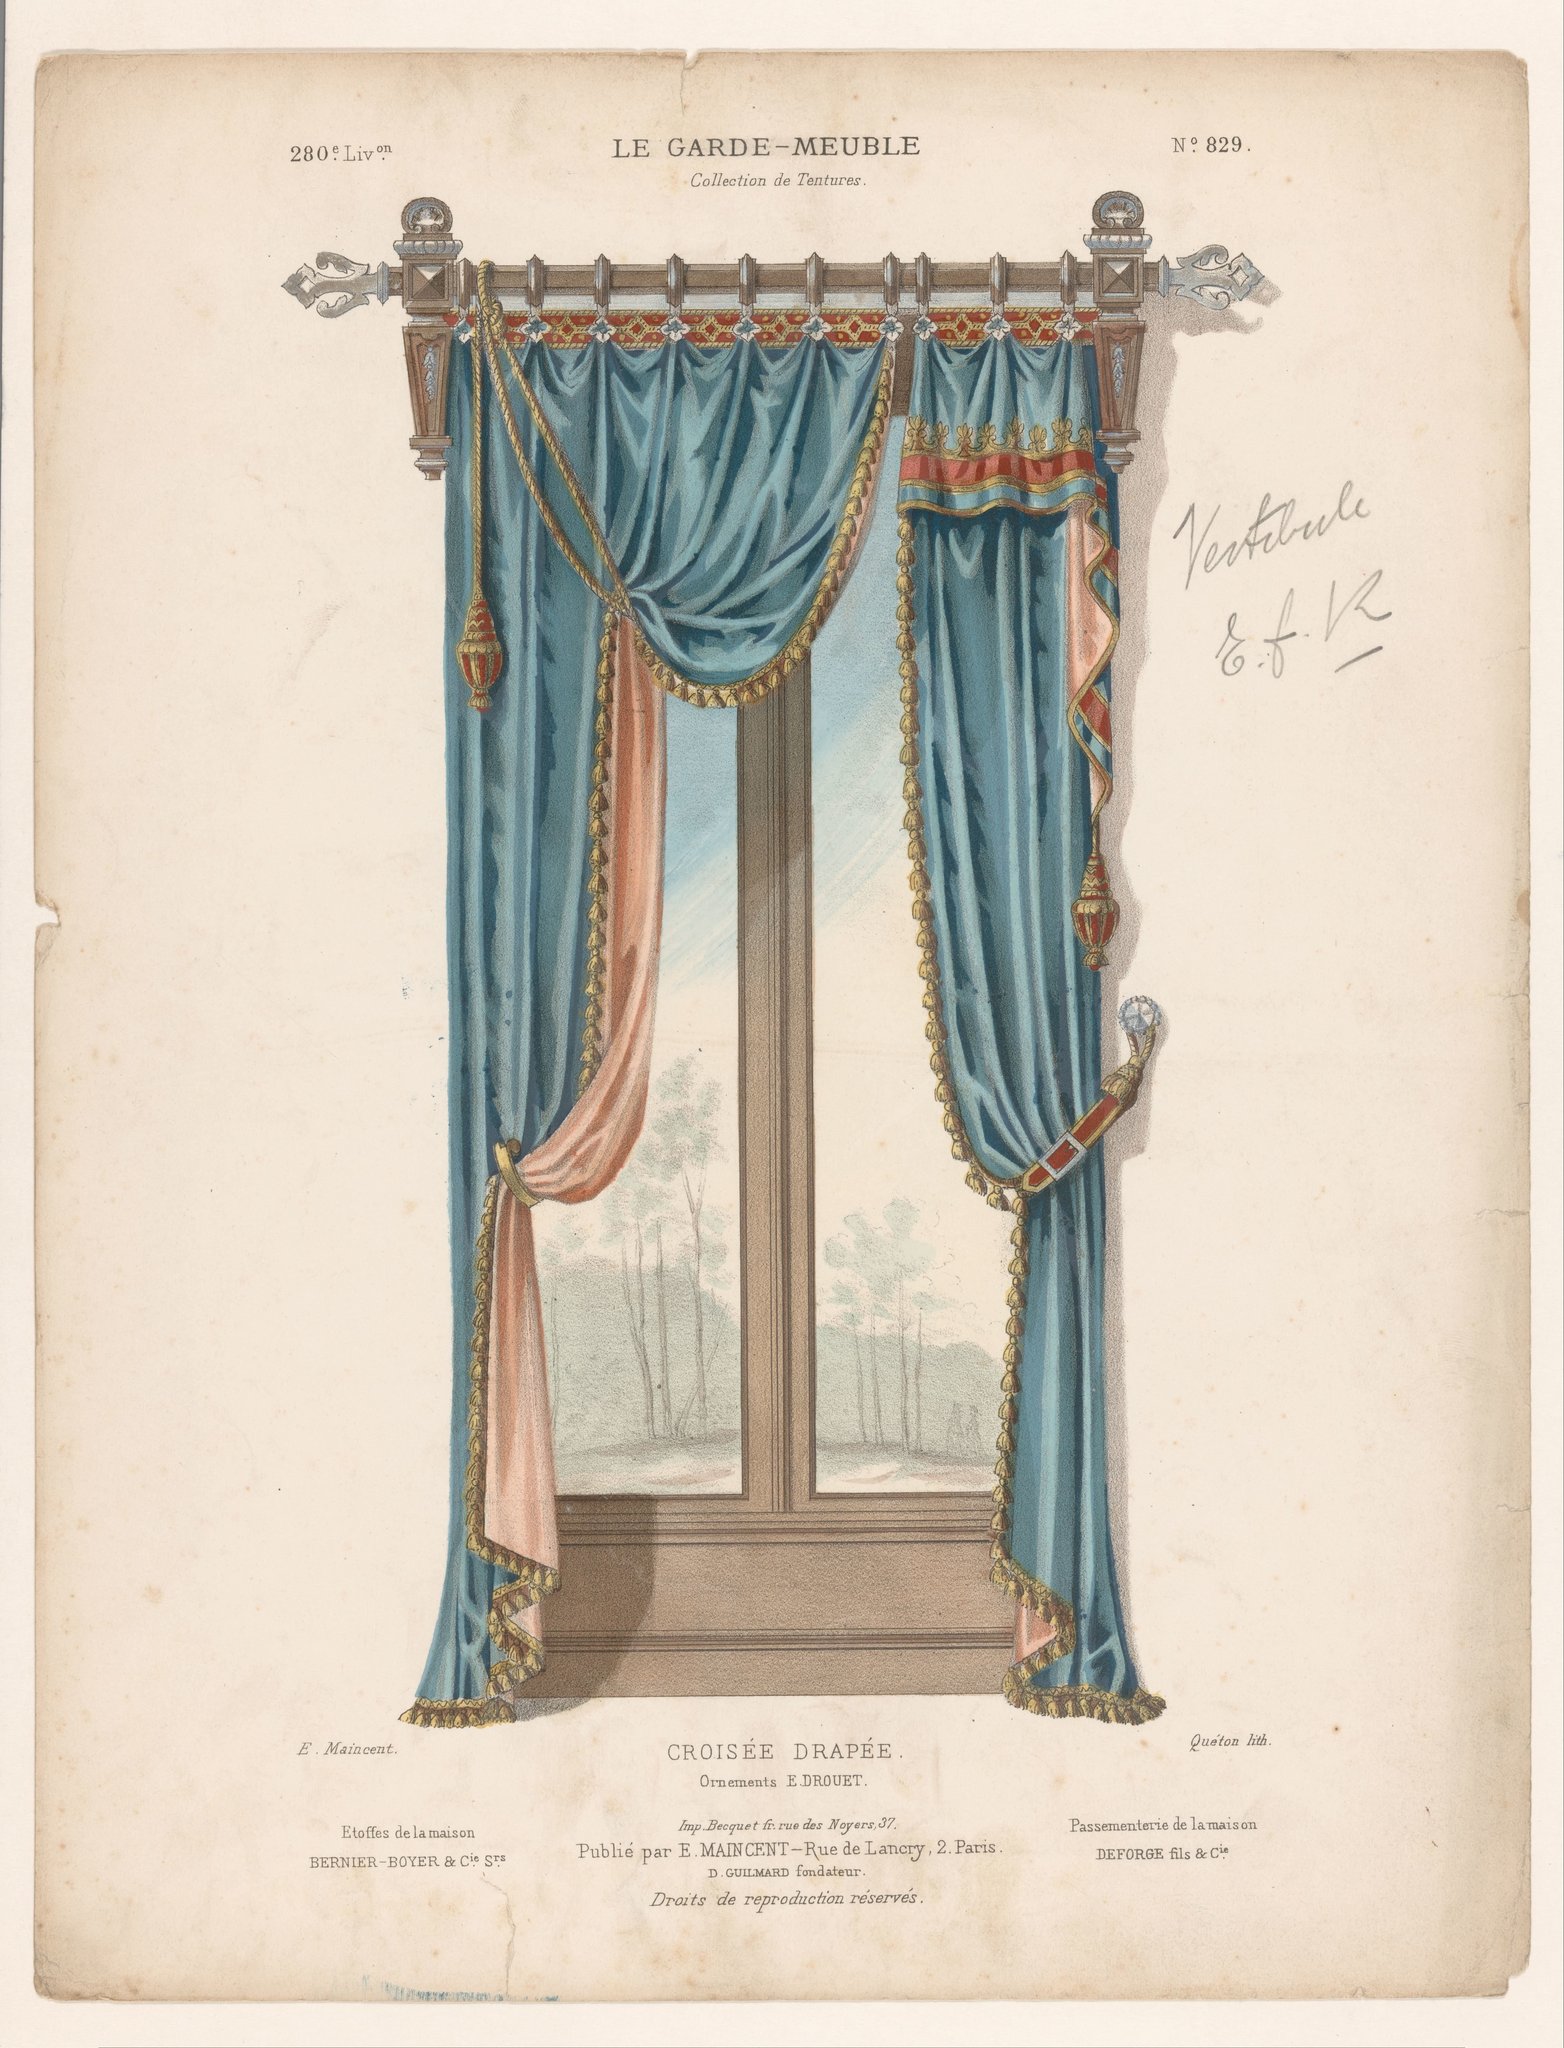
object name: print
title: Croisée drapée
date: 1885-1895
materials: paper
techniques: hand coloring, lithograph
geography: paris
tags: window, hangings and drapery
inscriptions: annotation: ‘Vestibule [...]’, : ‘Droits de reproduction réservés.’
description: Kruisvenster met gedrapeerde gordijnen. Prent uit 280e Livraison.